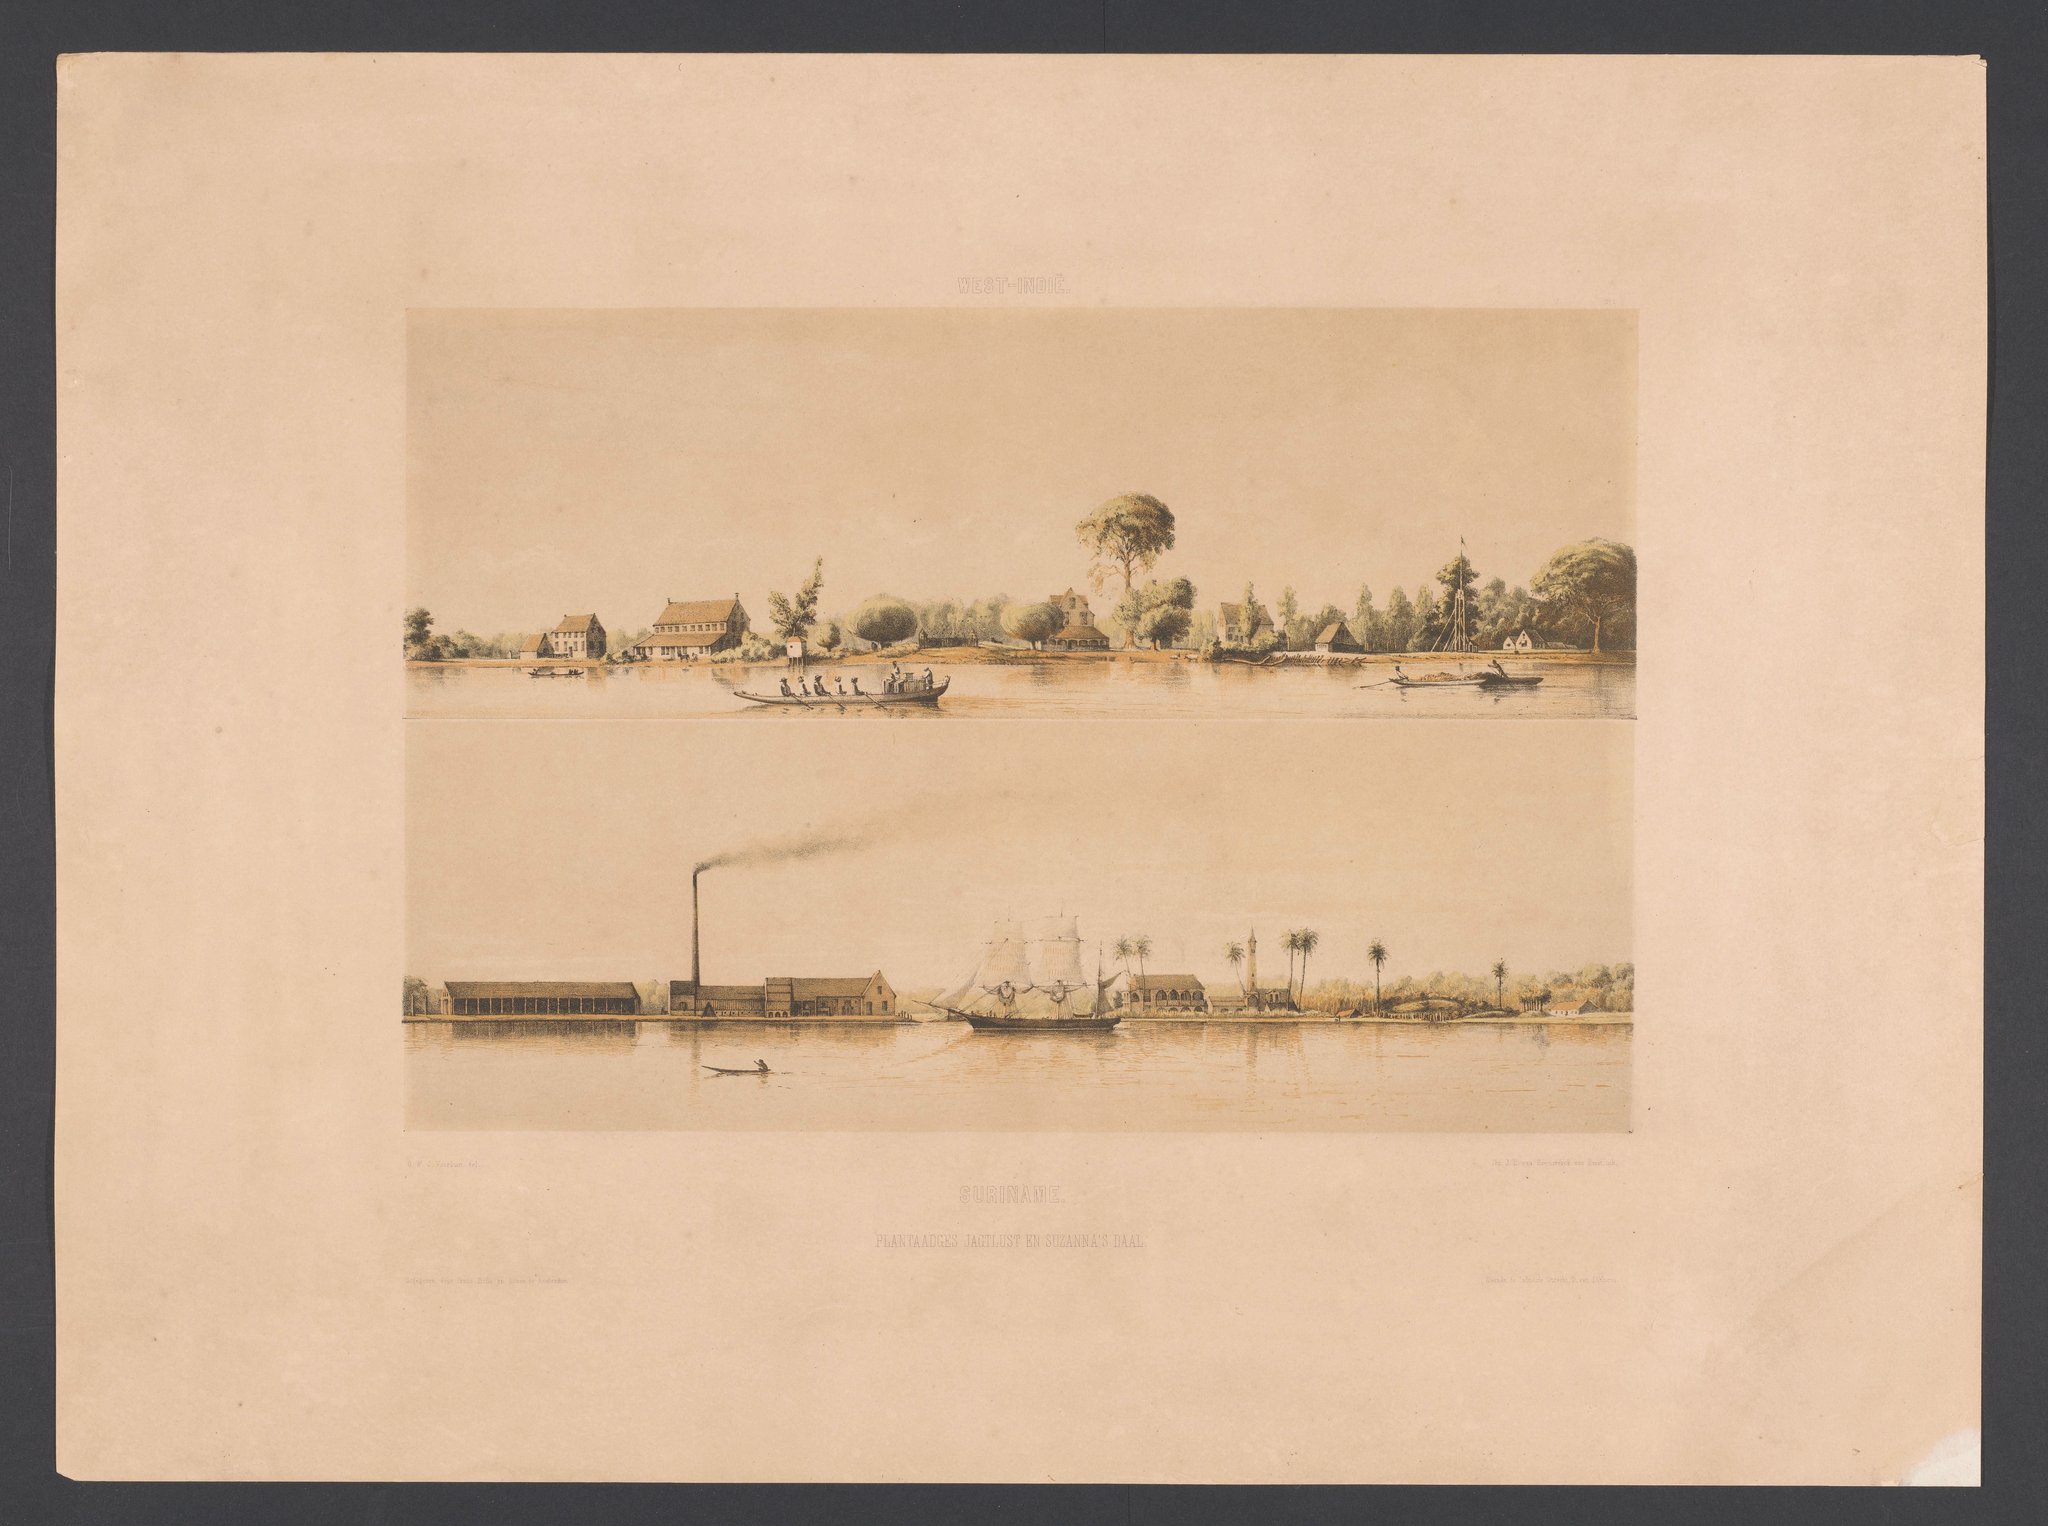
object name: print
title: West-Indië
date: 1860-1862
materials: paper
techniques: lithograph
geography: netherlands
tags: plantation, river, rowing-boat, canoe, etc., suriname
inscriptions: collector's mark: Lugt 2760, collector's mark: Lugt 2228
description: Gezichten op de plantages Jagtlust en Susanna's-daal aan de Surinamerivier in Suriname. Prent maakt deel uit van een omslag met zeventien bladen.